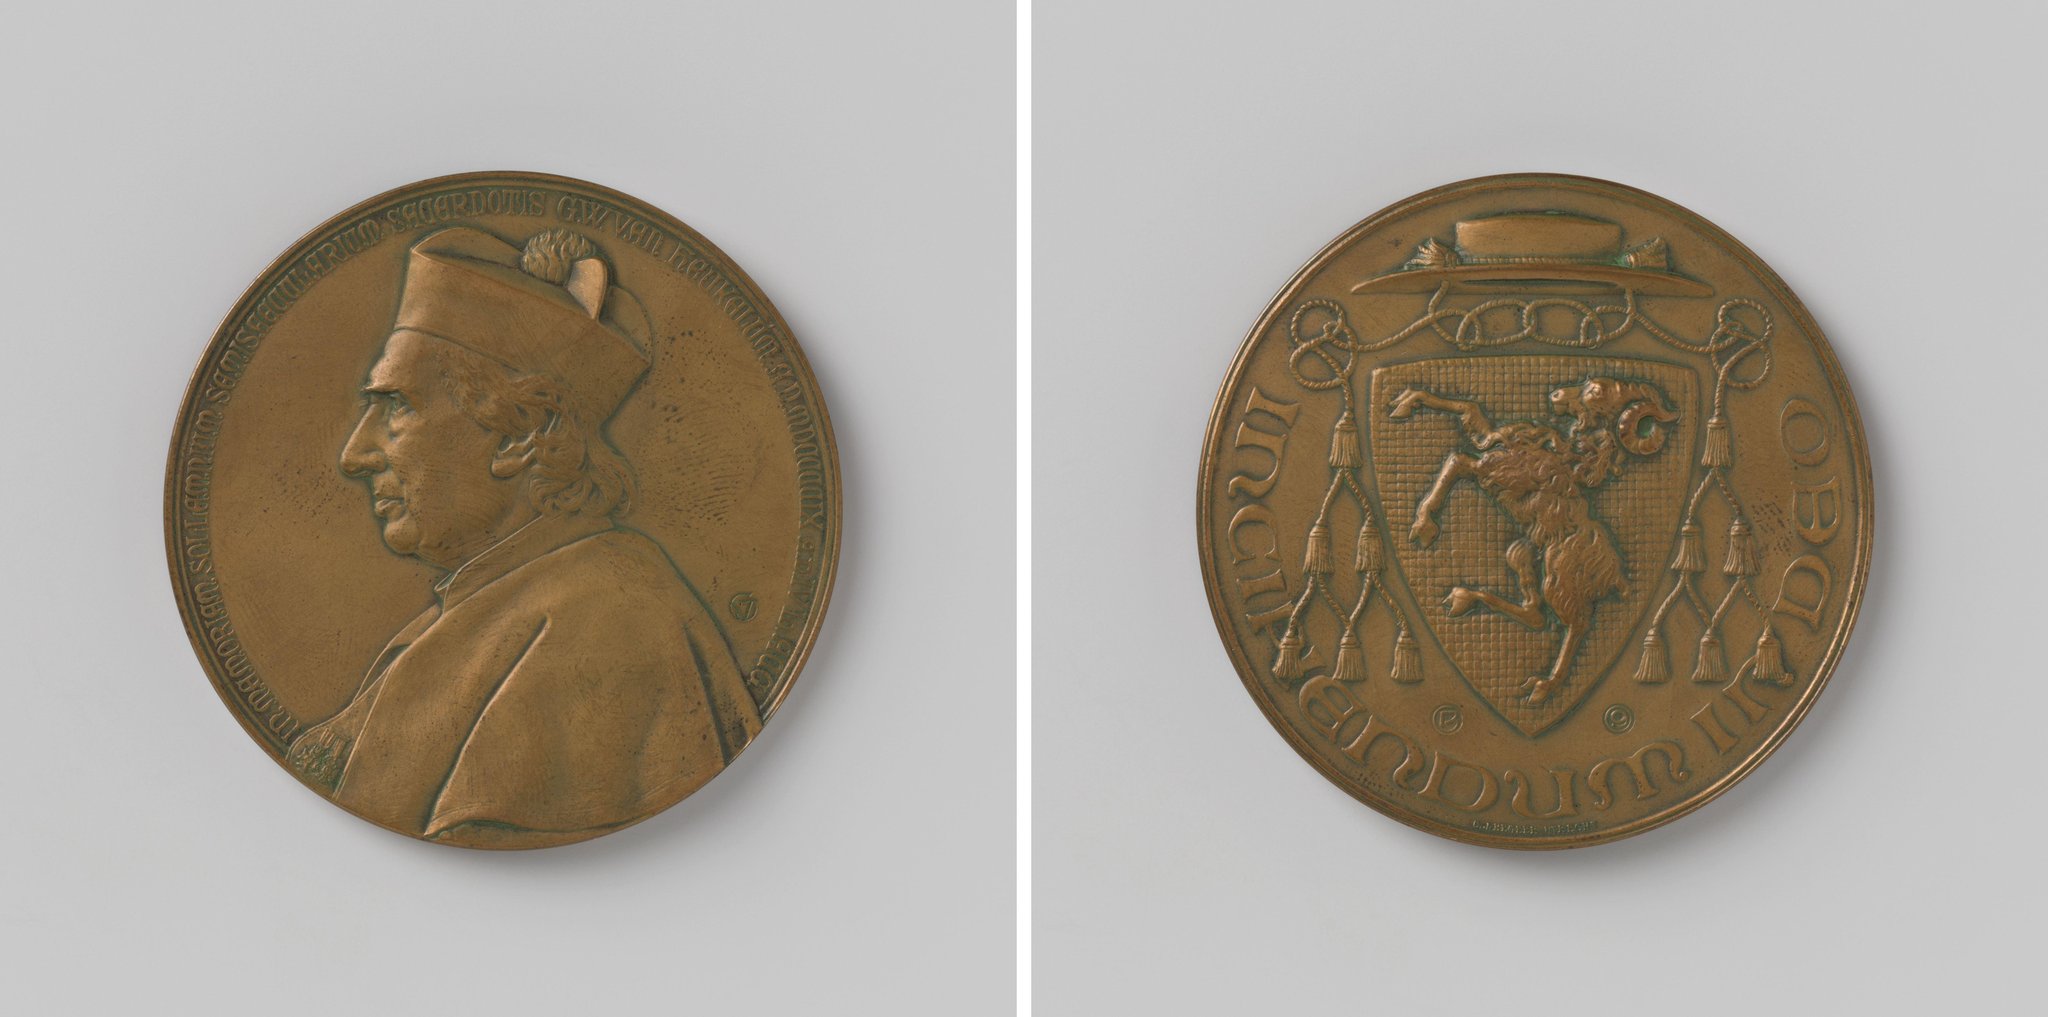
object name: honorary medal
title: Mgr. Gerardus Wilhelmus van Heukelum, penning geslagen ter ere van zijn vijftigjarig priesterschap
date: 1909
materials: bronze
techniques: striking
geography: utrecht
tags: gijsbertus wilhelmus van heukelum, utrecht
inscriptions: date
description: Bronzen penning. Voorzijde: borstbeeld van een man in priestersgewaad in profiel naar links met omschrift in gotische letters: IN MEMORIAM SOLLEMNIUM SEMISAECULARIUM SACERDOTIS G. W. VAN HEUKELUM A.D. MDCCCCIX AD IV D. AUG. Keerzijde: door een kardinaalshoed gedekt wapen (van van Heukelum) waarop een bok, omgeven door koorden en kwasten met omschrift: IN CIPENDUM IN DEO - C. I. BEGEER UTRECHT. randschrift: BRONS. Gesigneerd; voorzijde en keerzijde. Gedateerd.